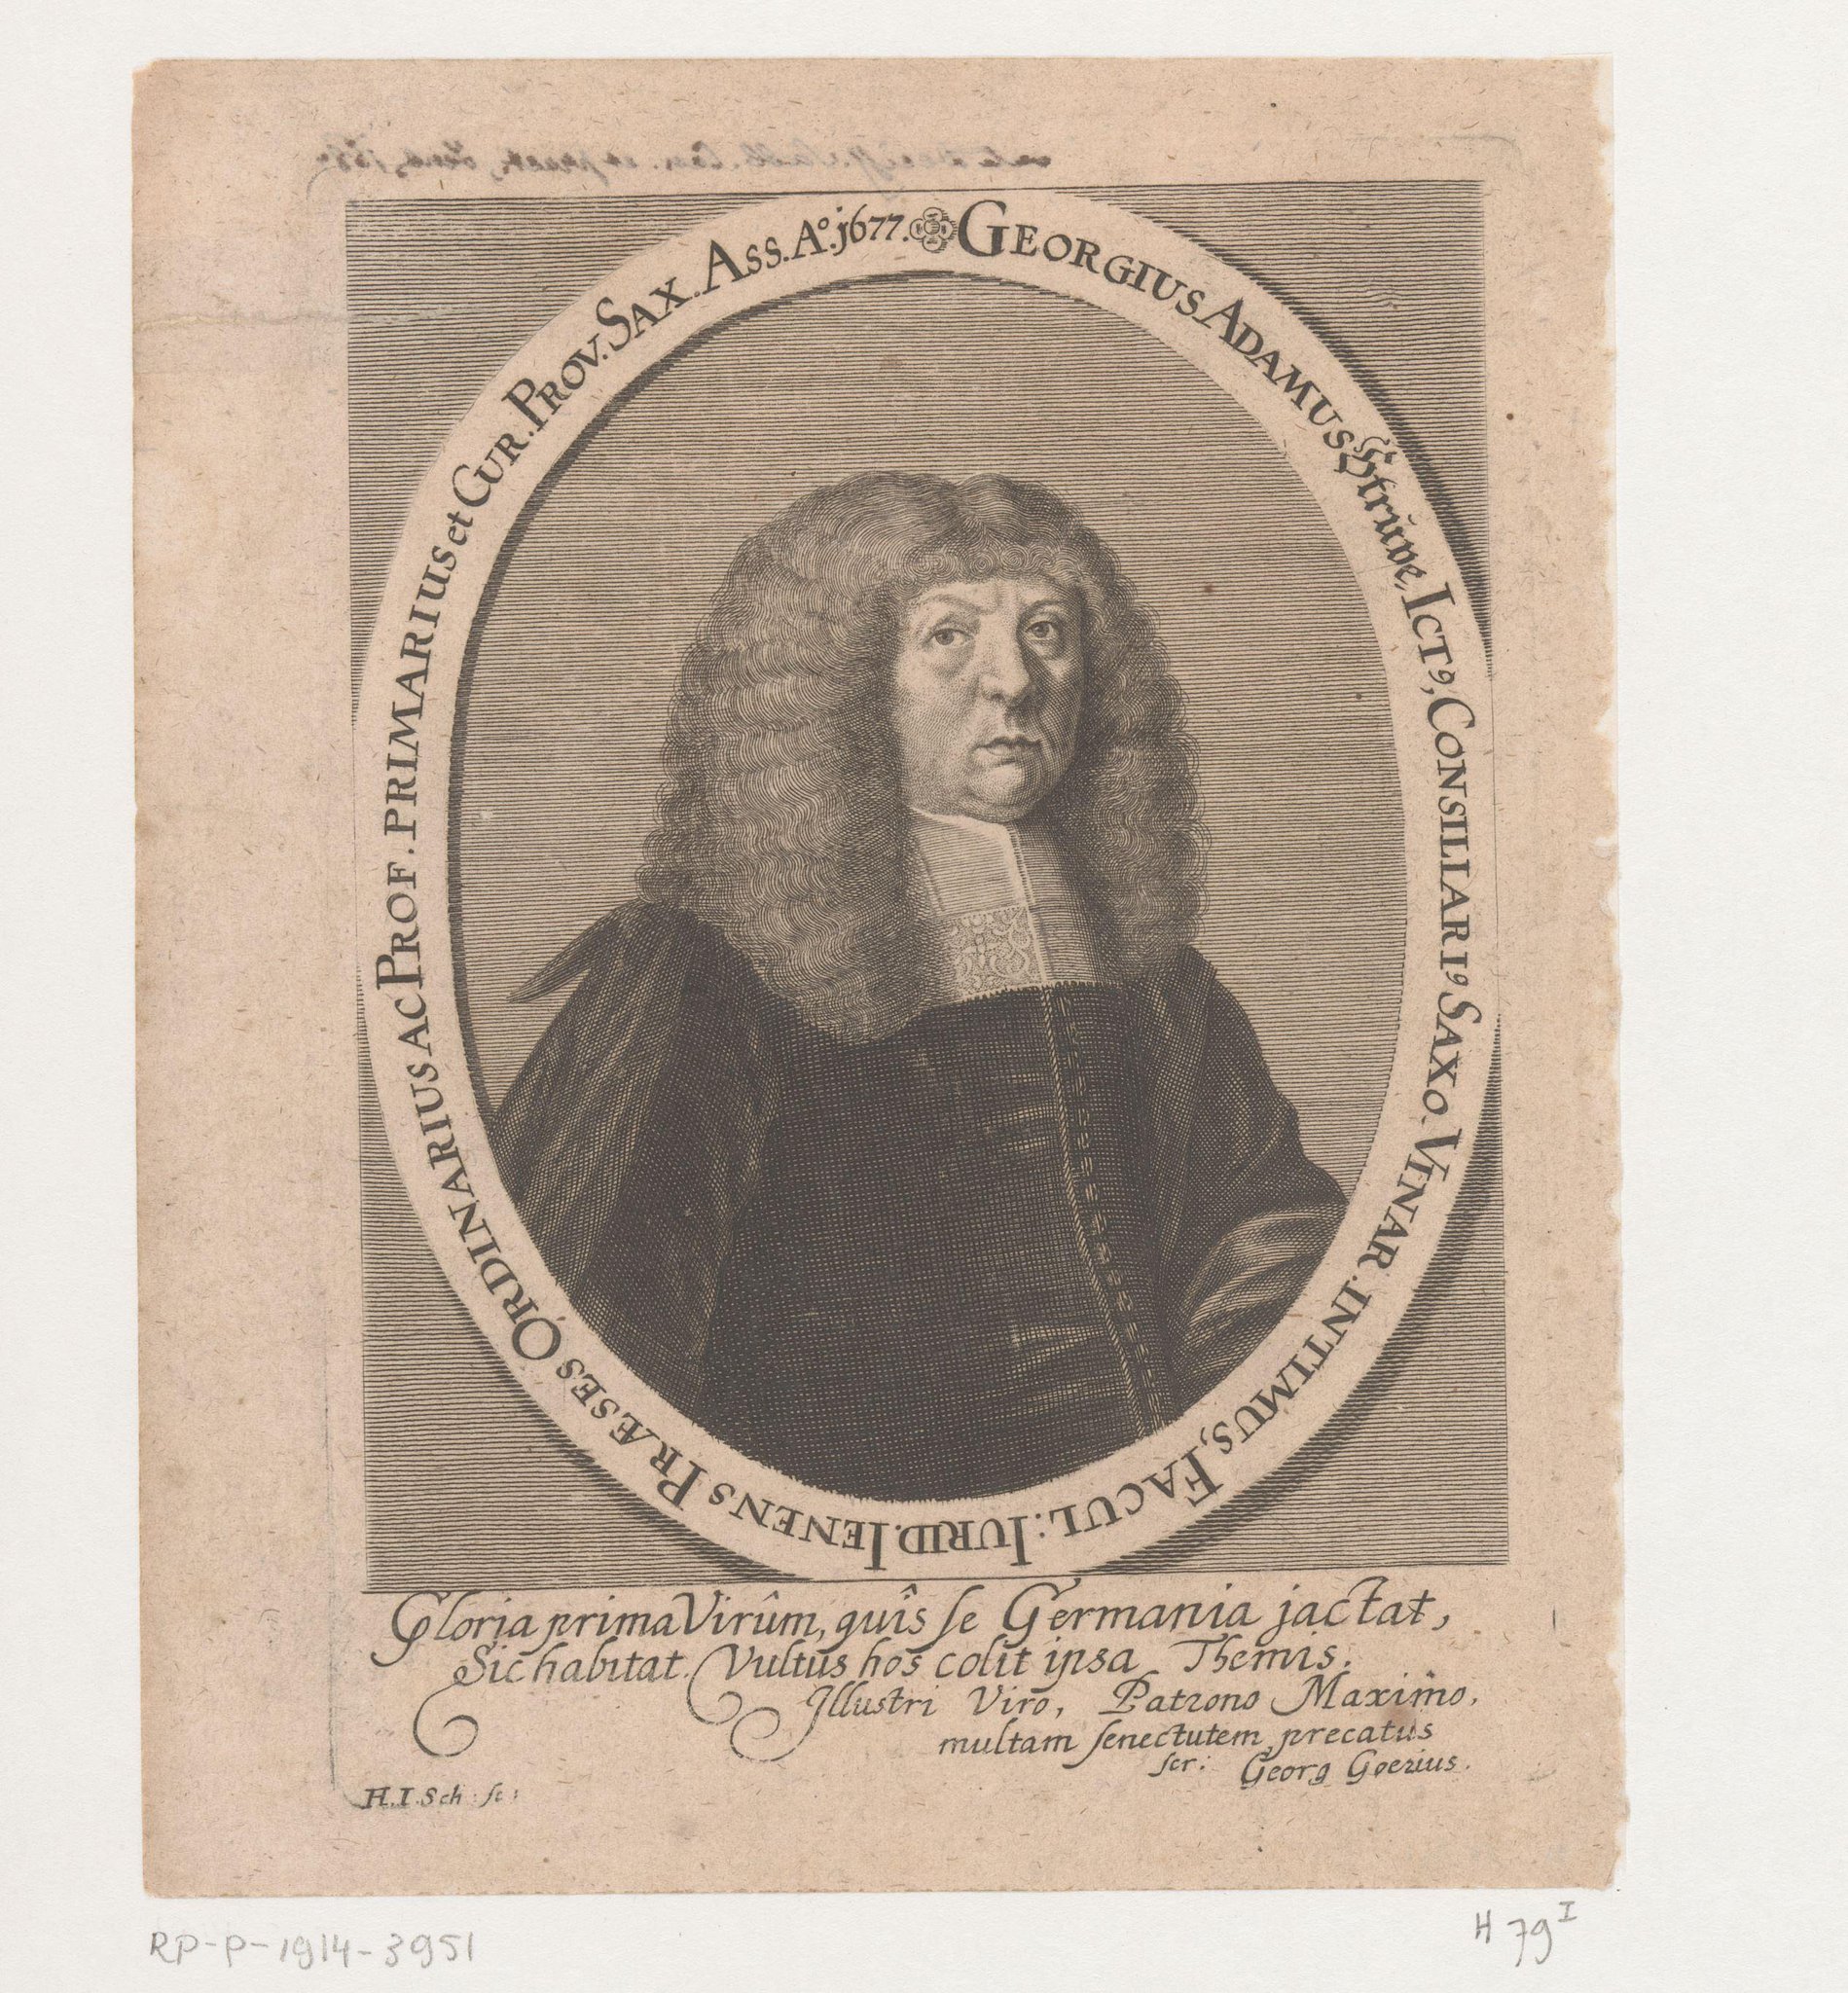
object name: print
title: Portret van Georg Adam Struve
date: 1677-1689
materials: paper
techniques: engraving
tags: further education (+ portrait of teacher, professor), historical persons, lawyer, attorney at law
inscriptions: collector's mark: Lugt 2228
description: Tekst in het Latijn in de omlijsting en in de ondermarge.